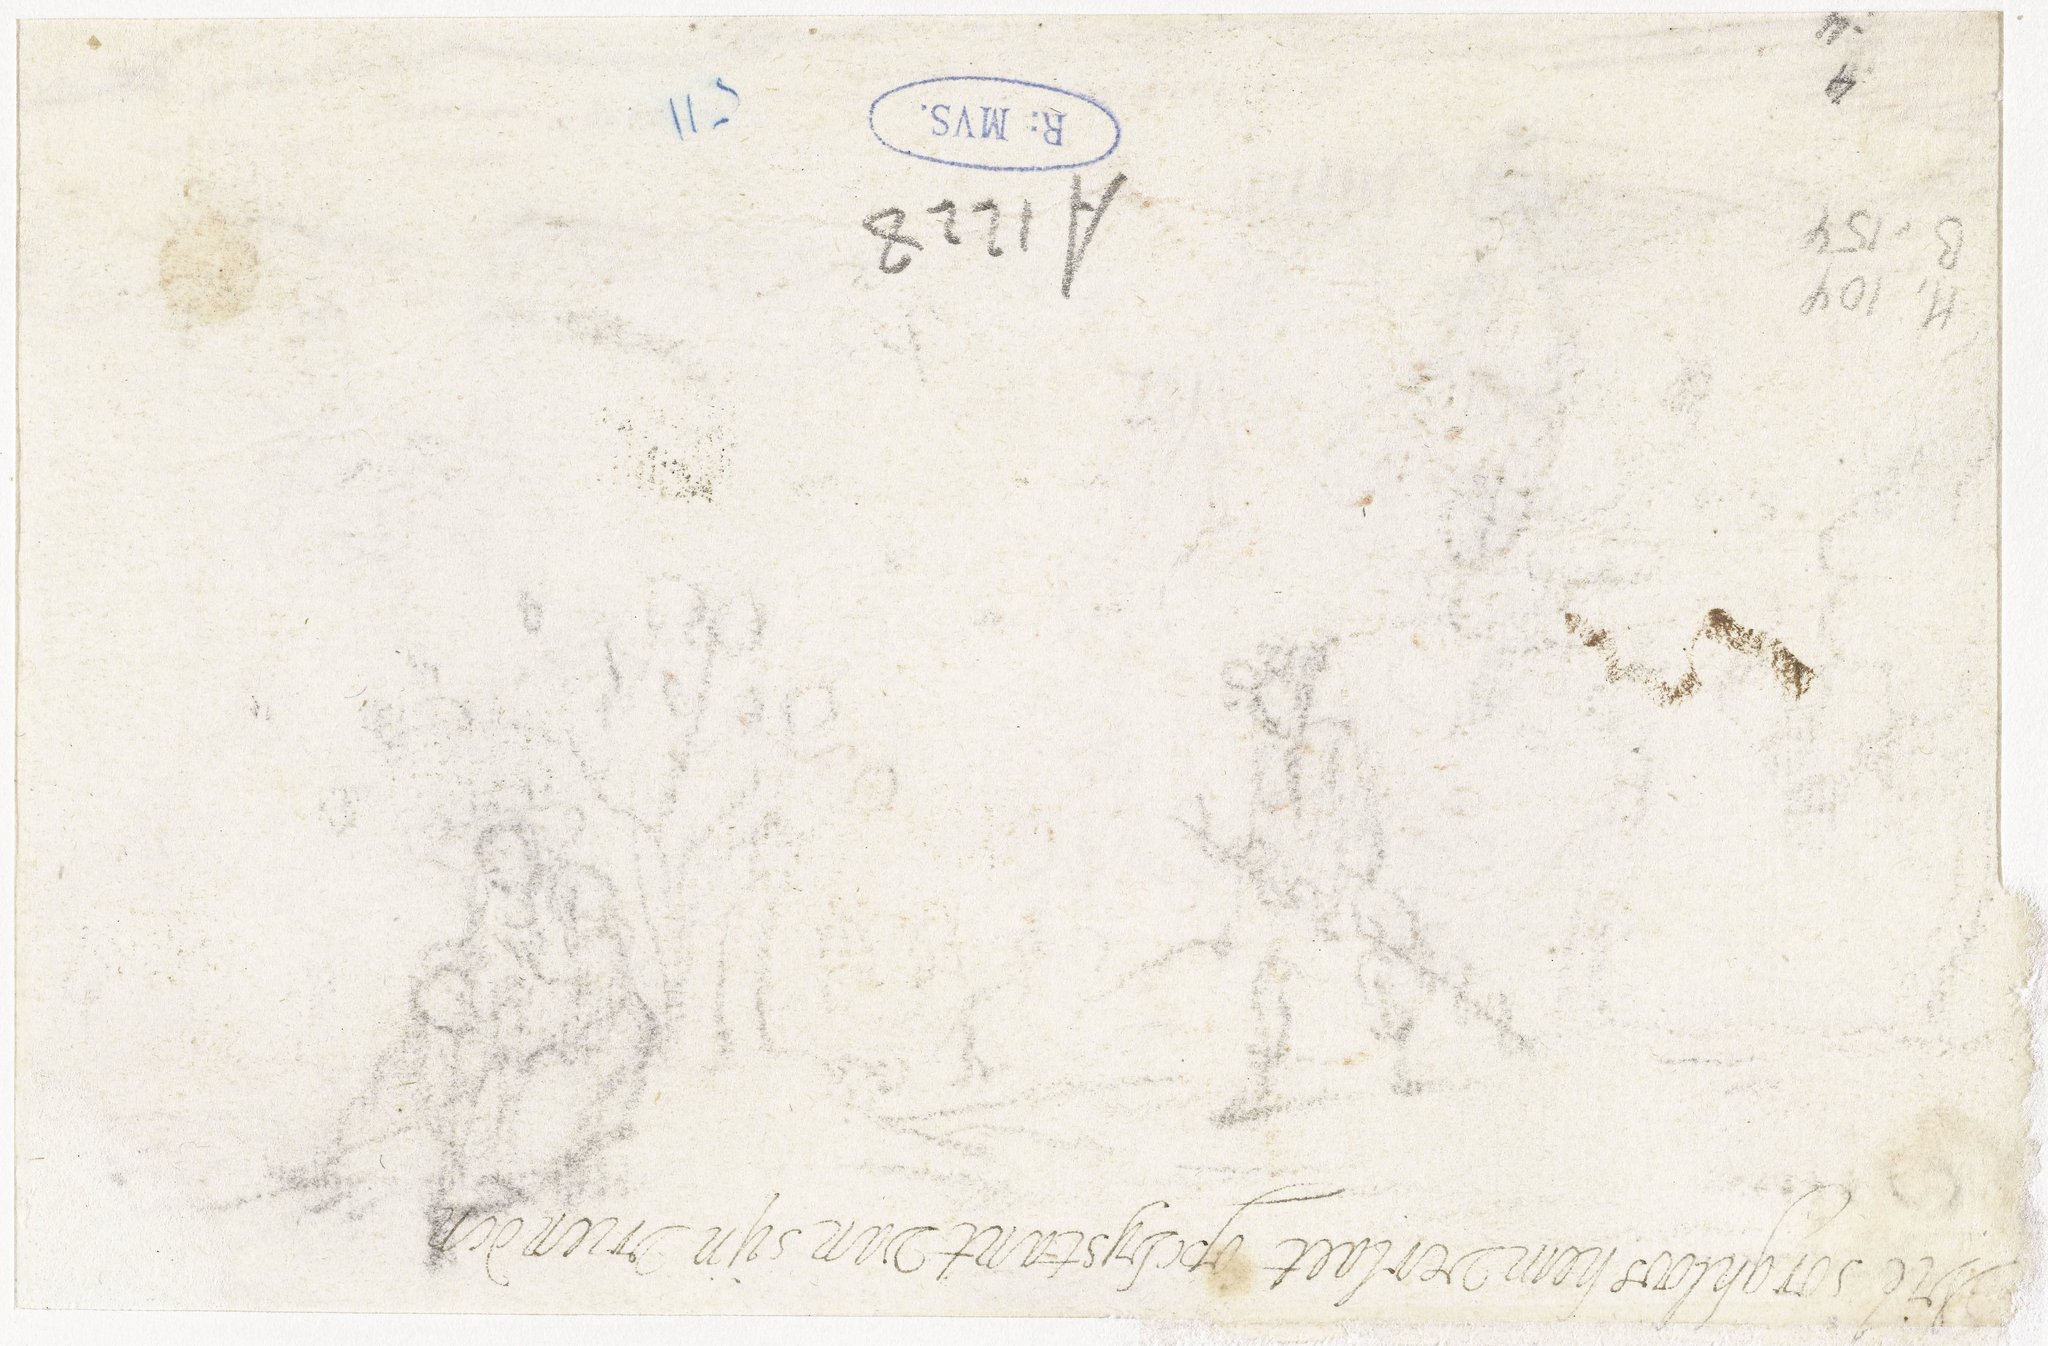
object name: drawing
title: Pastorale scène met twee figuren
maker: gesina ter borch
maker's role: draughtsman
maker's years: 1633-1690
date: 1652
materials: chalk, paper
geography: zwolle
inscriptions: inscription: ‘Wie sorghloos hem verlaet op bystant van sijn vrienden’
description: Pastorale scène met twee figuren (spiegelbeeld van de afbeelding op recto). Voorstudie voor de illustratie op folio 10 van het Poëzie-album.